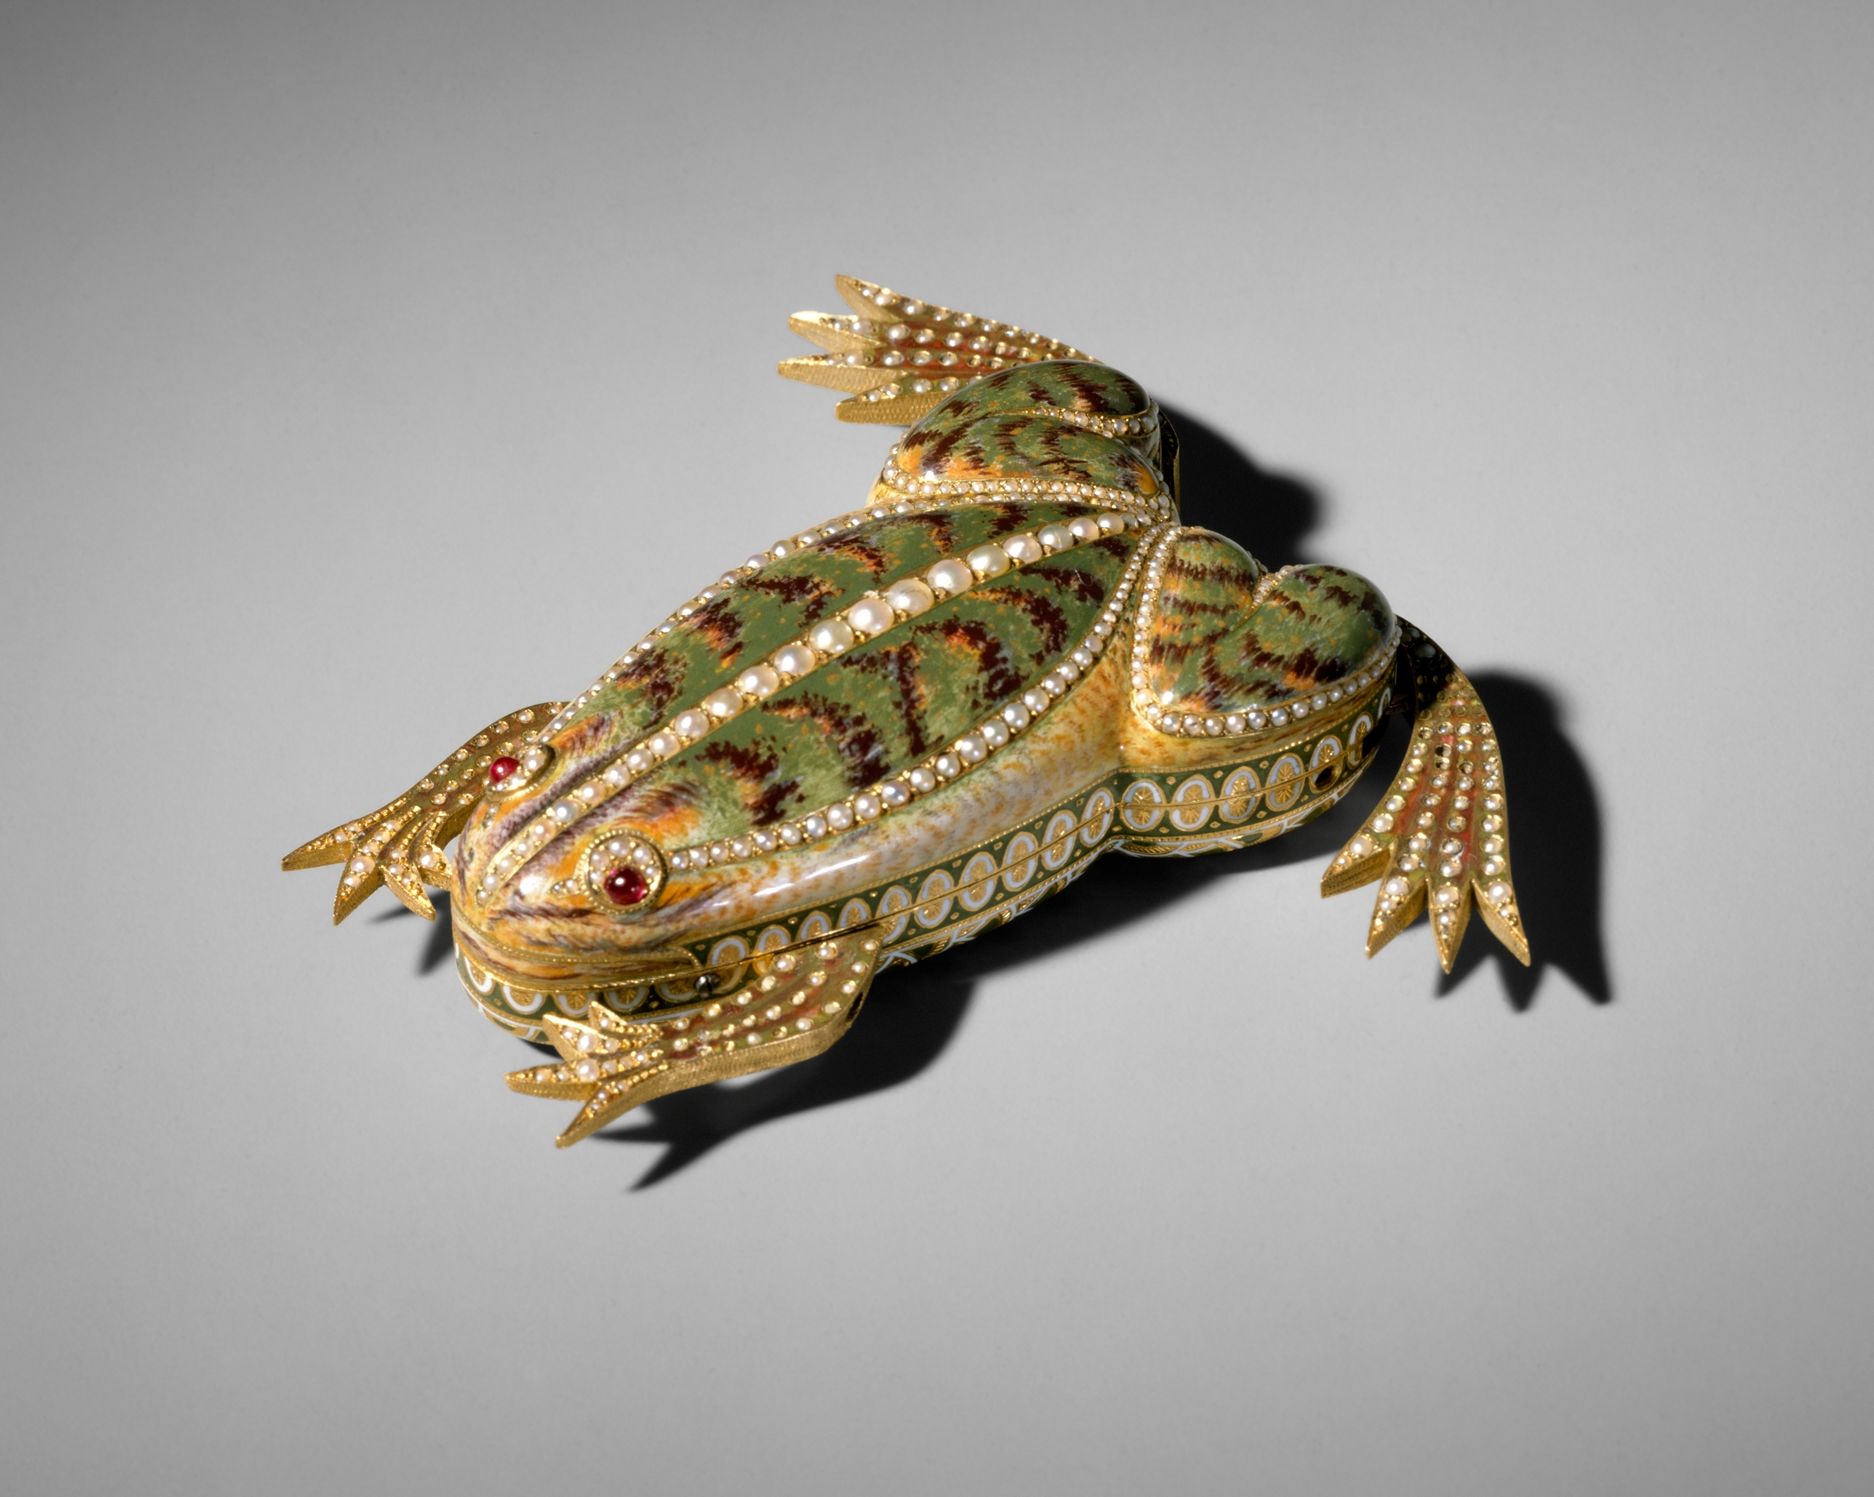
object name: automaton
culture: swiss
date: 1820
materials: diamond, enamel, gold, gemstone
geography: switzerland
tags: frogs